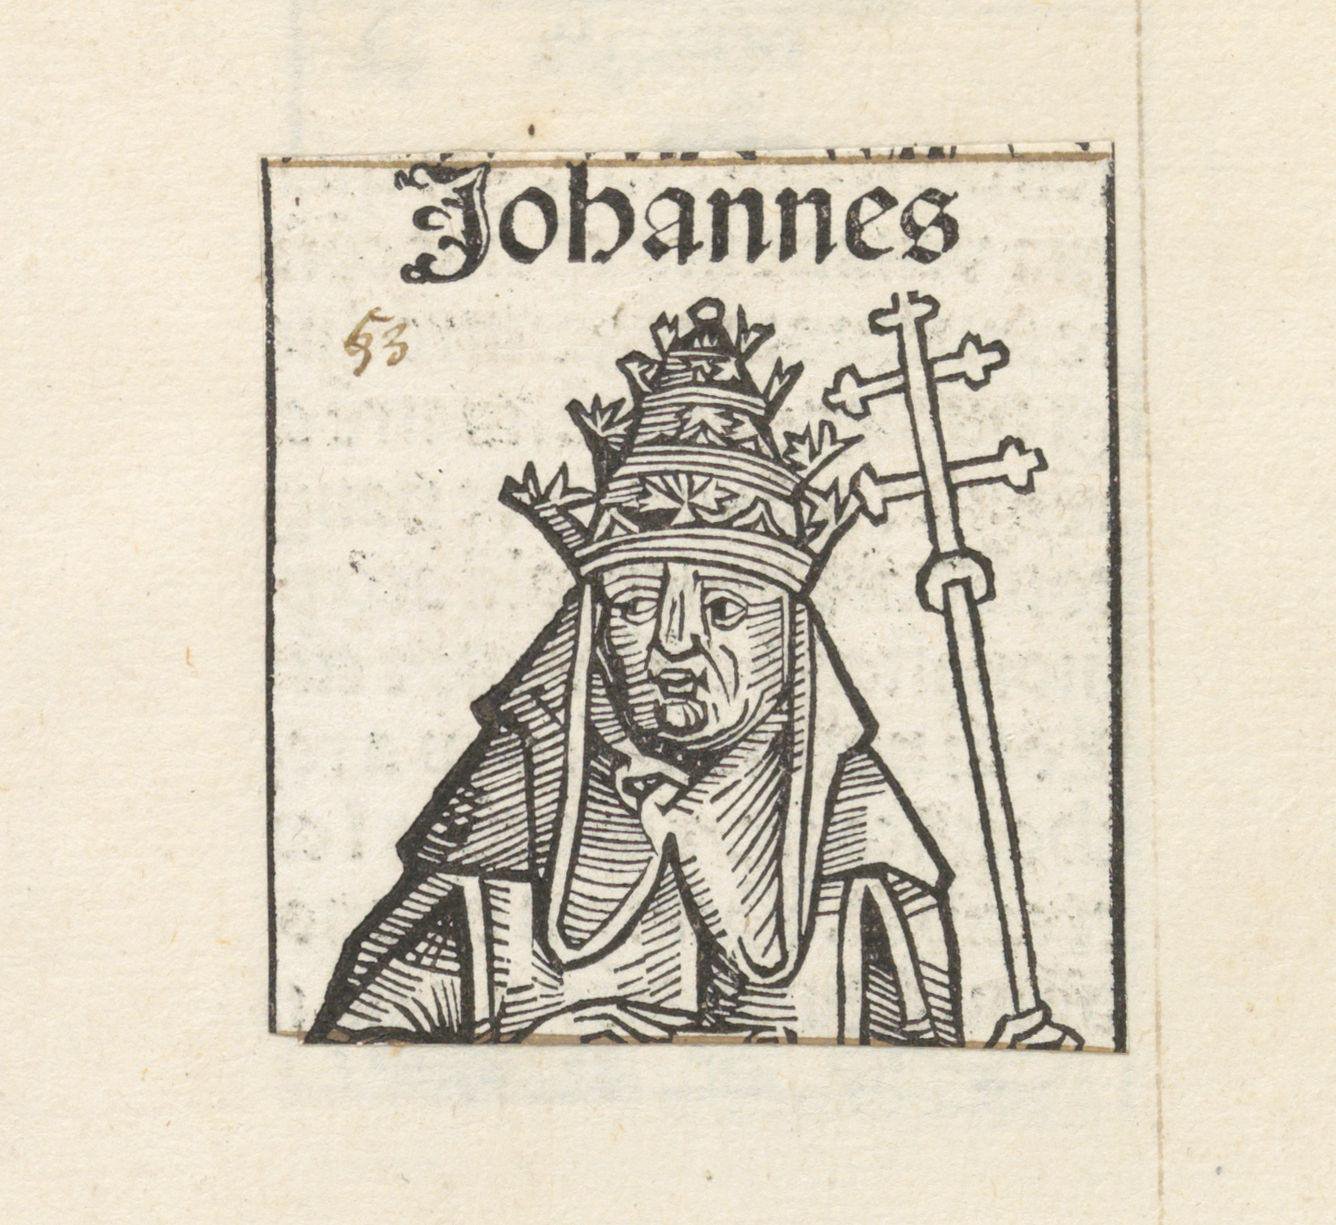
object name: book illustration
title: Johannes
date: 1493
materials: paper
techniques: letterpress printing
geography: nuremberg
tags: rome, pope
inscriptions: inscription: ‘55’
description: Een paus. Hij draagt een tiara en heeft een staf met een dubbel kruis in zijn handen. De voorstelling is onderdeel van de opeenvolging pausen in de Liber Chronicarum. De tekst identificeert de man als Johannes III. De prent maakt deel uit van een album.